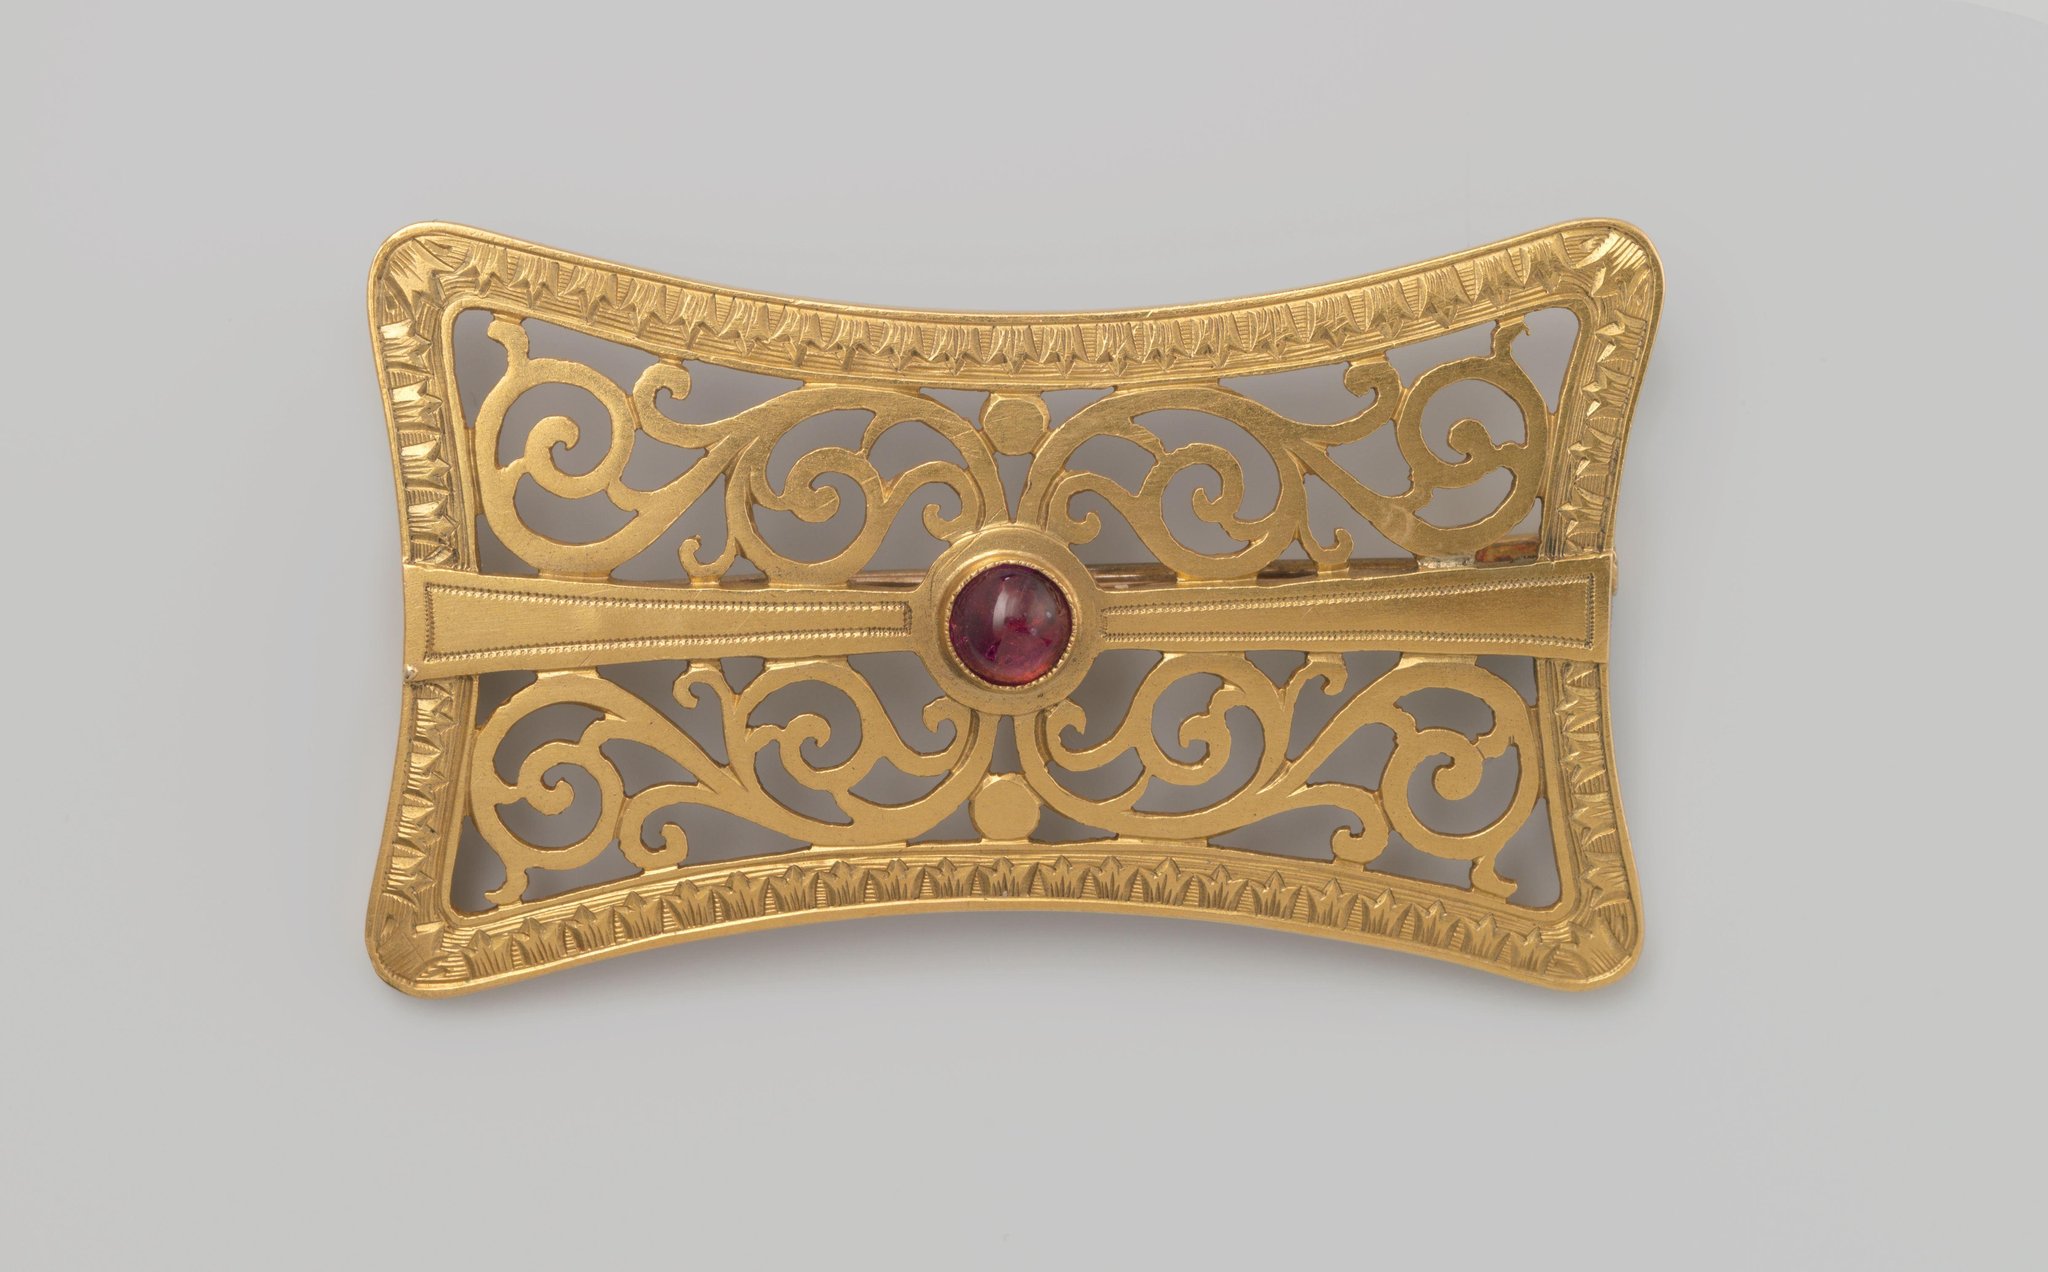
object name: brooch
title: Broche van opengewerkt goud met centraal een roodpaarse steen van glas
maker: Anonymous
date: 1915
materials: glass, gold, paste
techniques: embroidery, engraving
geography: netherlands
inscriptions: alloy mark: ‘(oud) eikenblad’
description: Vlakke broche van opengewerkt goud met krulornamenten voorzien van kanonsluiting. Centraal een ronde, cabochon geslepen, roodpaarse steen van glas.